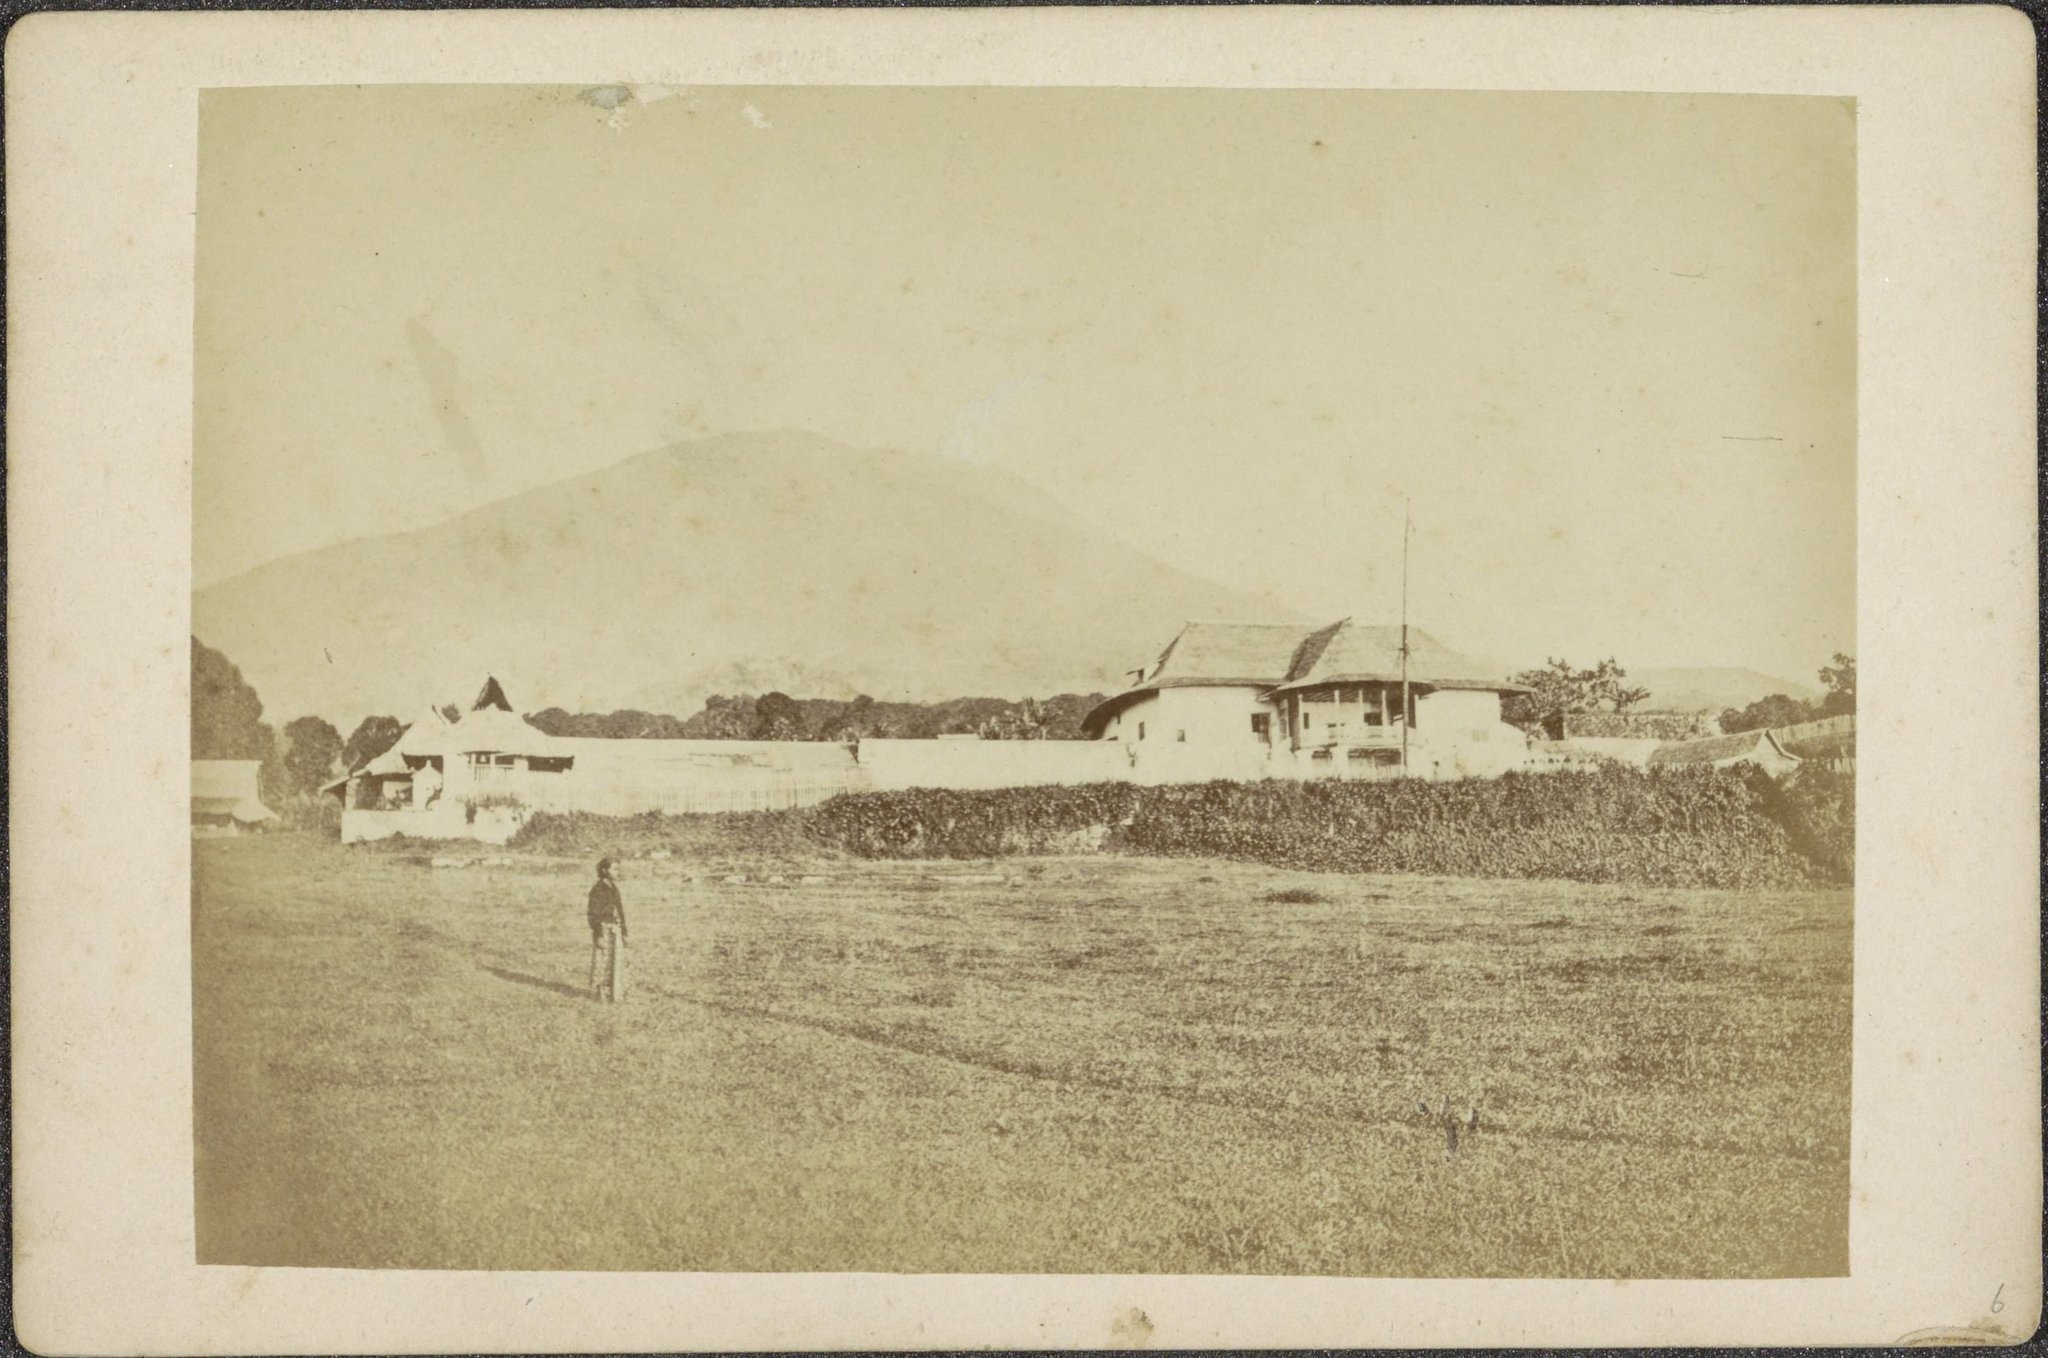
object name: cabinet photograph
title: Gezicht op de woning van de sultan van Ternate met op de achtergrond de Gunung Gamalama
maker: Anonymous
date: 1860-1900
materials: cardboard, paper, photographic support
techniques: albumen print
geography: ternate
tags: palace, volcano, dutch east indies, the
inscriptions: inscription: ‘Molukken. De berg van Ternate rookende, voor de woning van den Sultan.’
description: Onderdeel van Album met foto's van de Molukken.